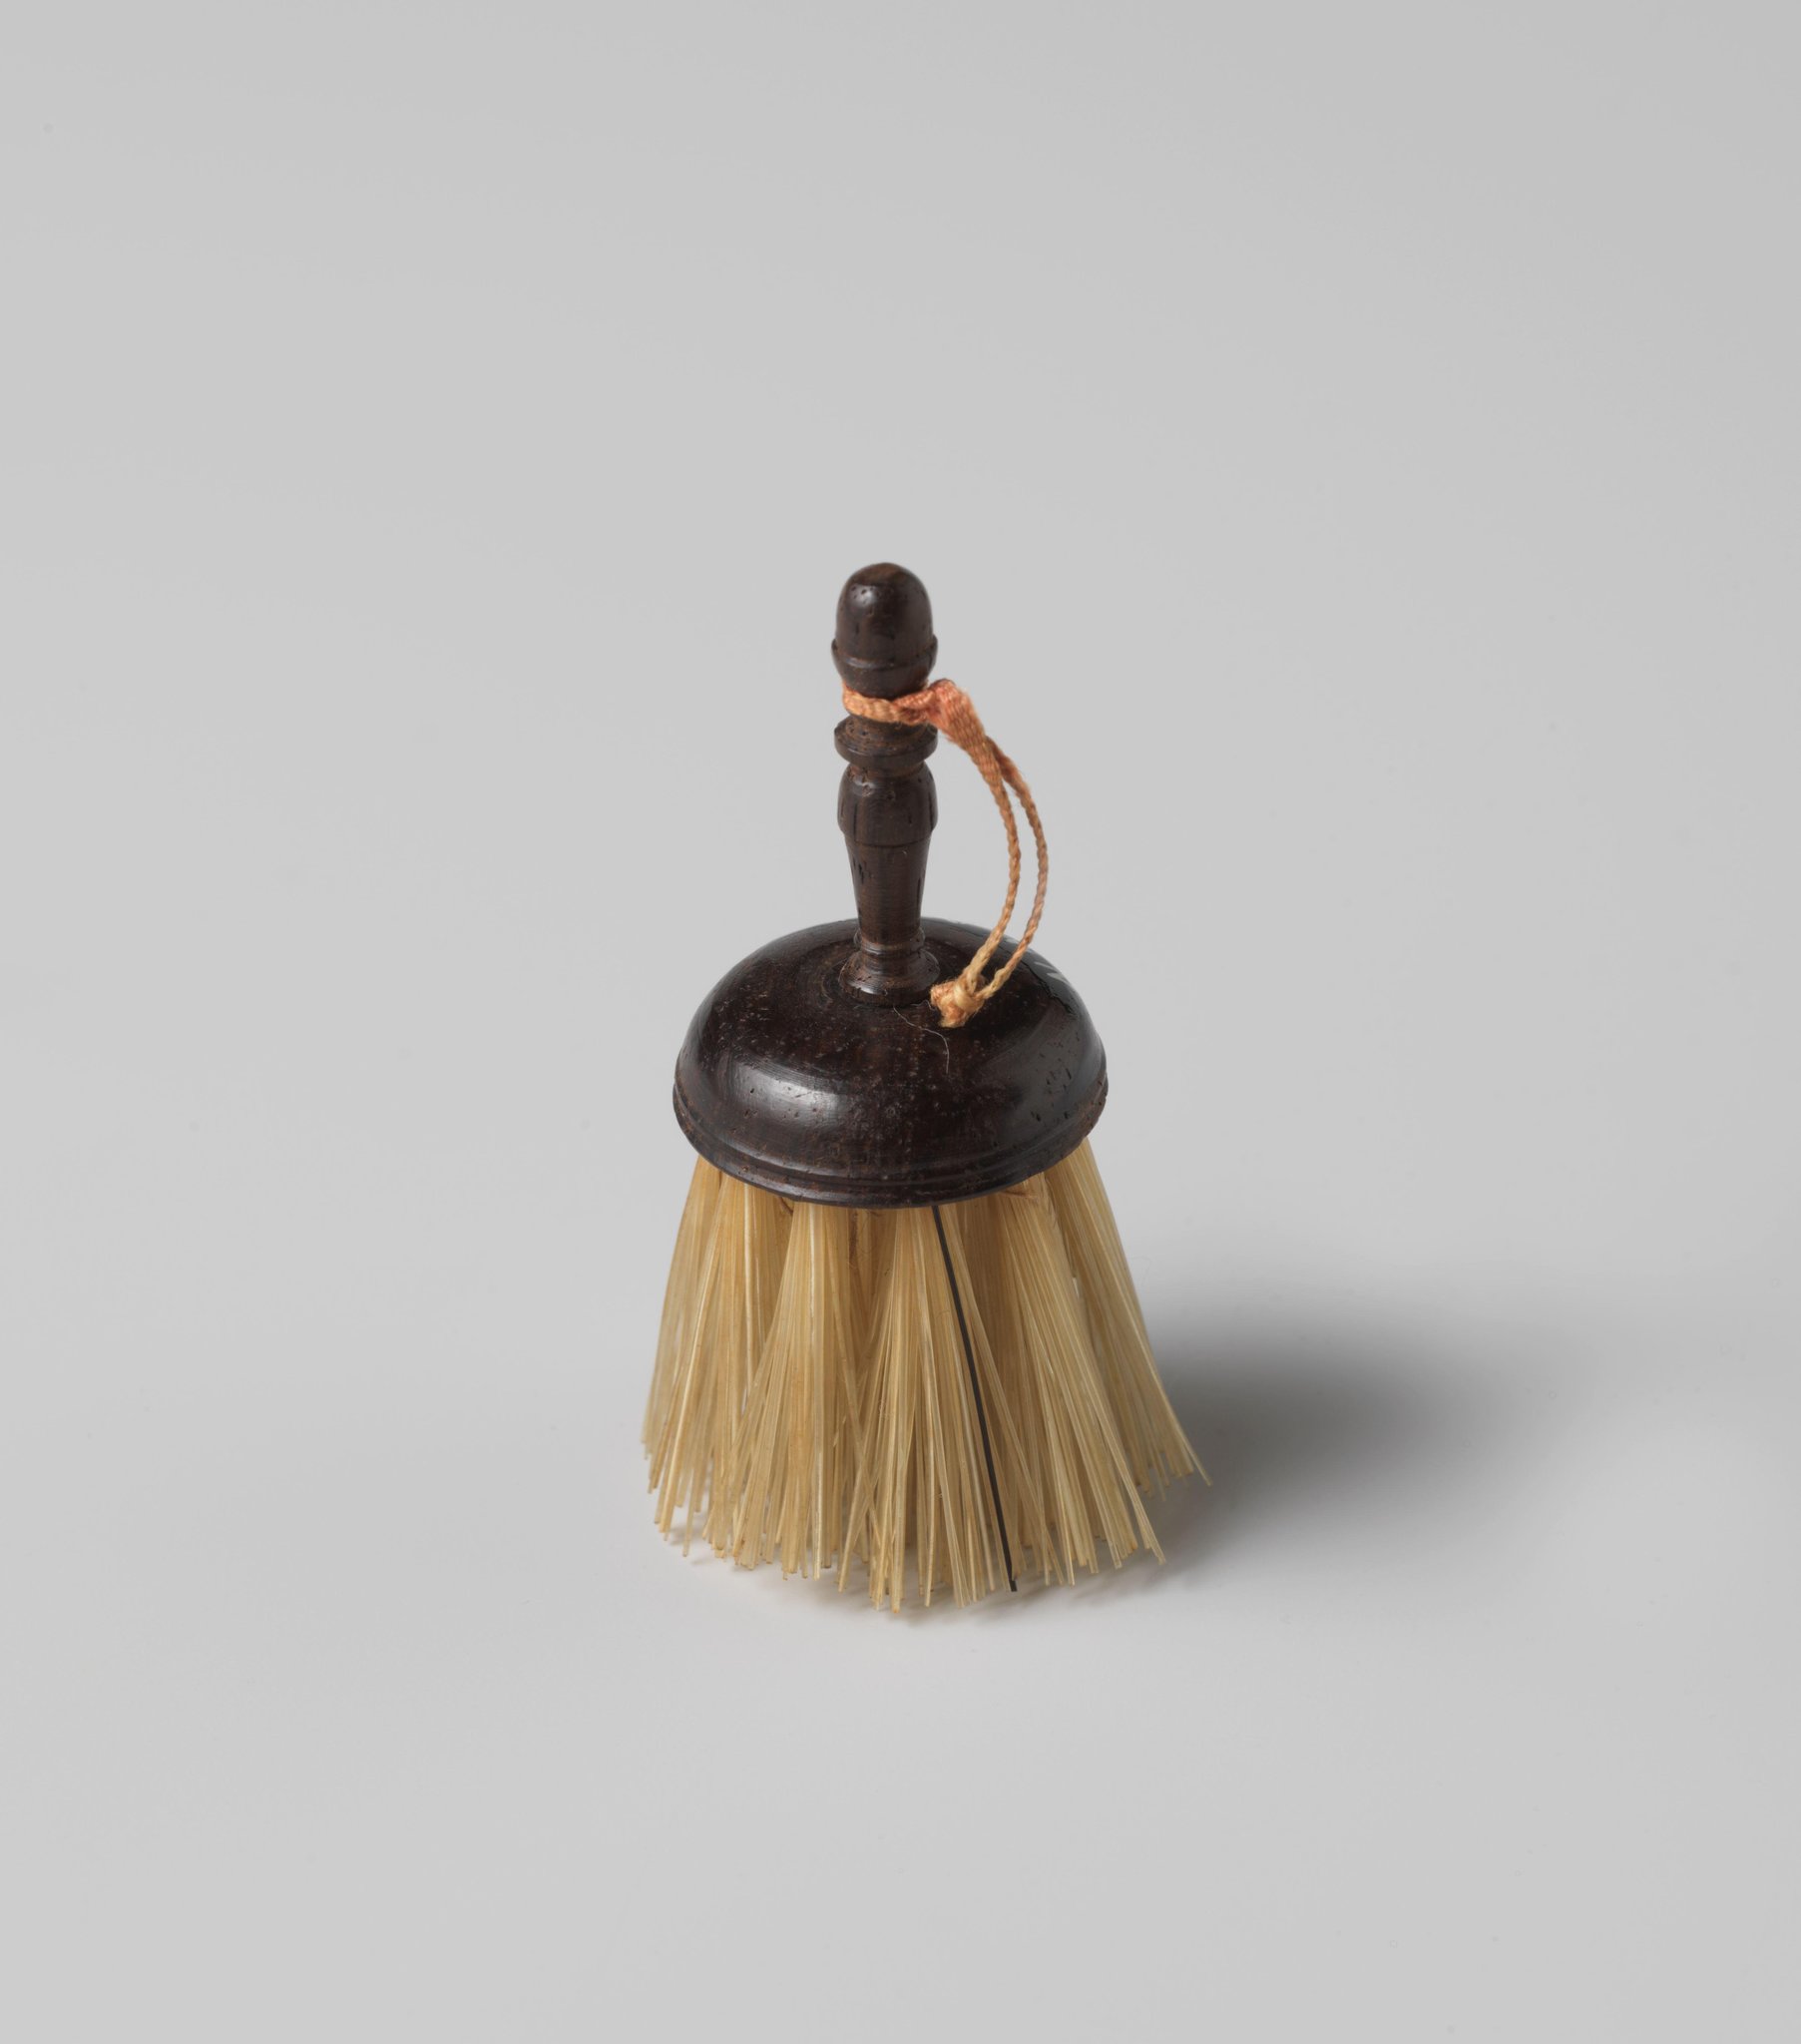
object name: veger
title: Borstel met ronde kop en geprofileerde steel, waaraan roze band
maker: Anonymous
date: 1675-1699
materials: wood, silk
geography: amsterdam